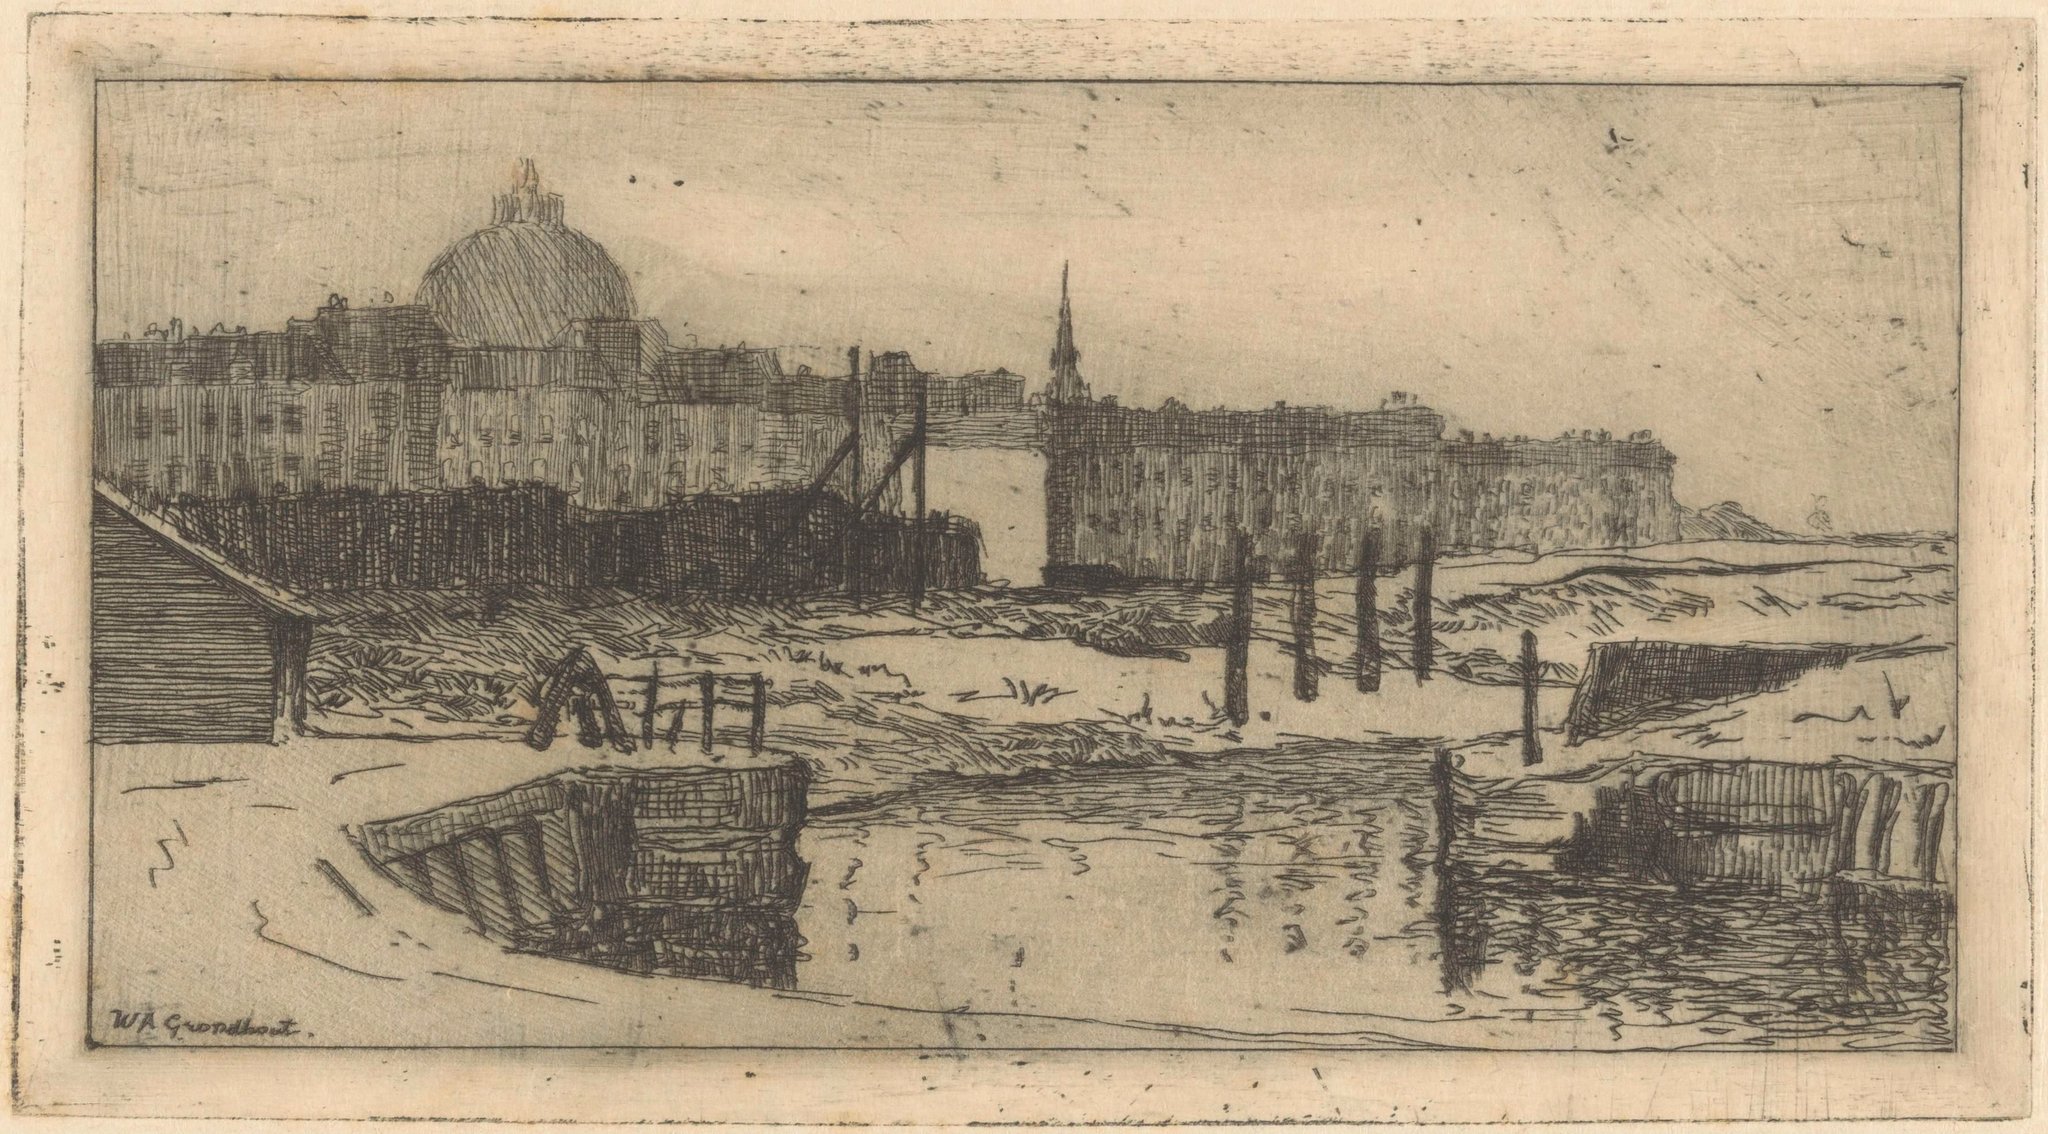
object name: print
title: Huizenbouw in Den Haag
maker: willem adrianus grondhout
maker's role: draughtsman, painter, print maker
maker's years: 1878-1934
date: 1888-1934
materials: paper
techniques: etching, intaglio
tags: building-site, the hague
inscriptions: collector's mark: Lugt 2228